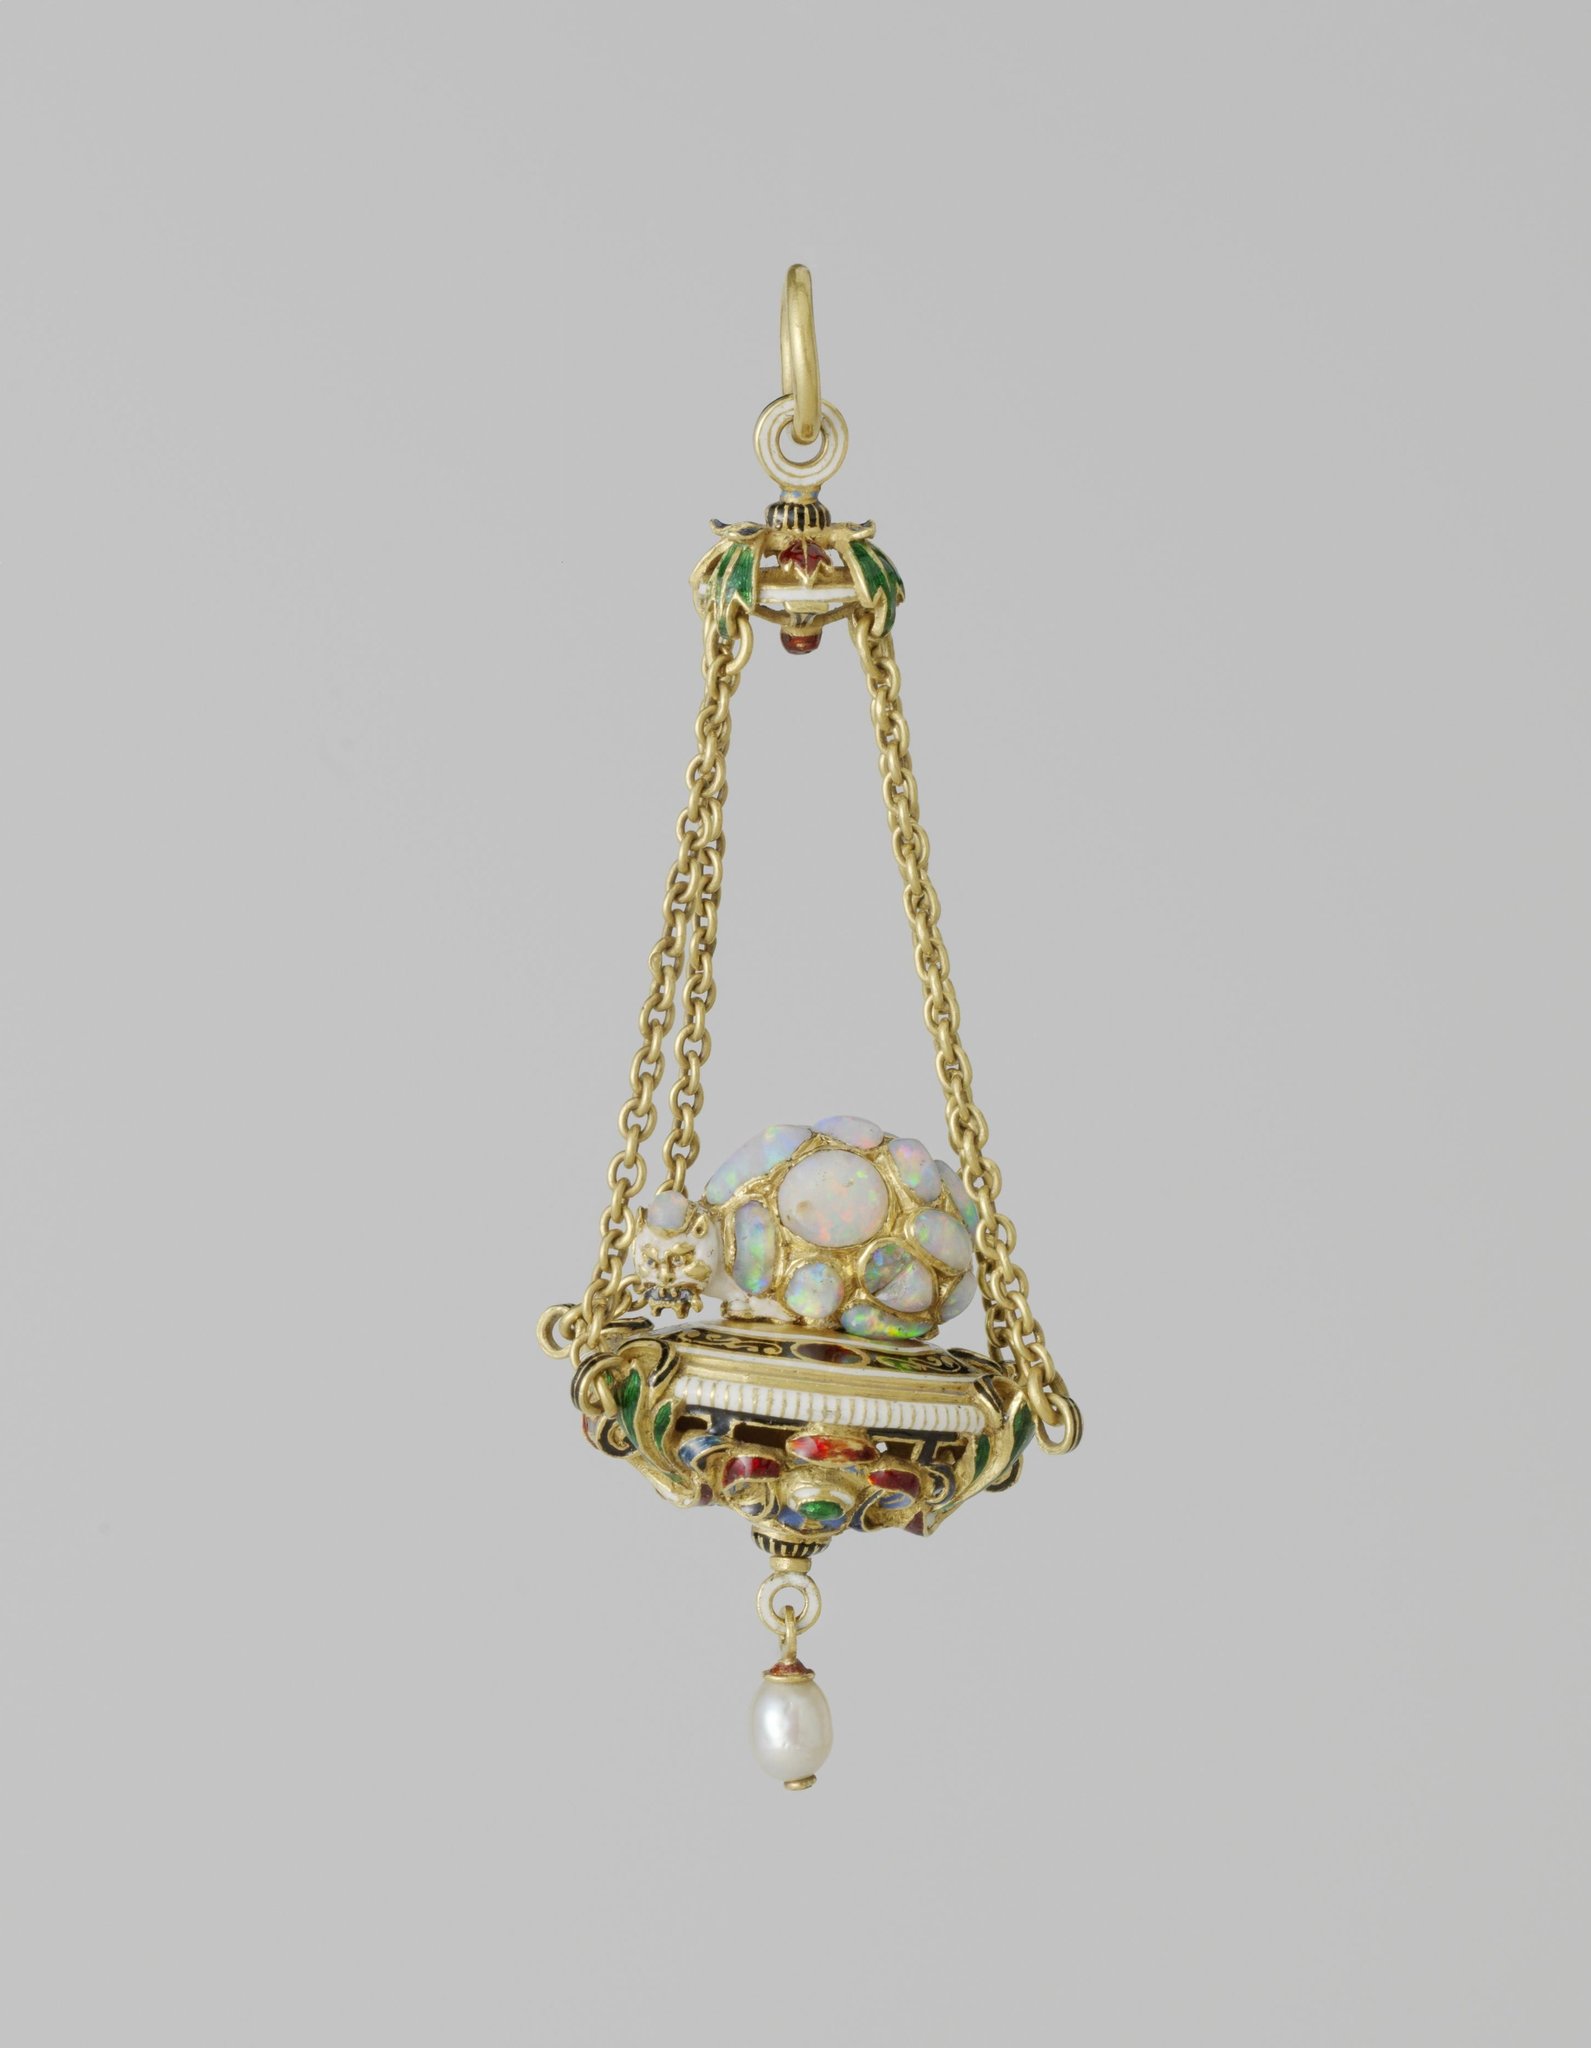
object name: pendant jewelry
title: Hanger in de vorm van een monster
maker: Anonymous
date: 1600-1620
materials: opal, pearl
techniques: enameling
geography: germany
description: Pendant, monster. Gold, opals, pearl and enamel. Germany or Spain, c. 1600-1620.